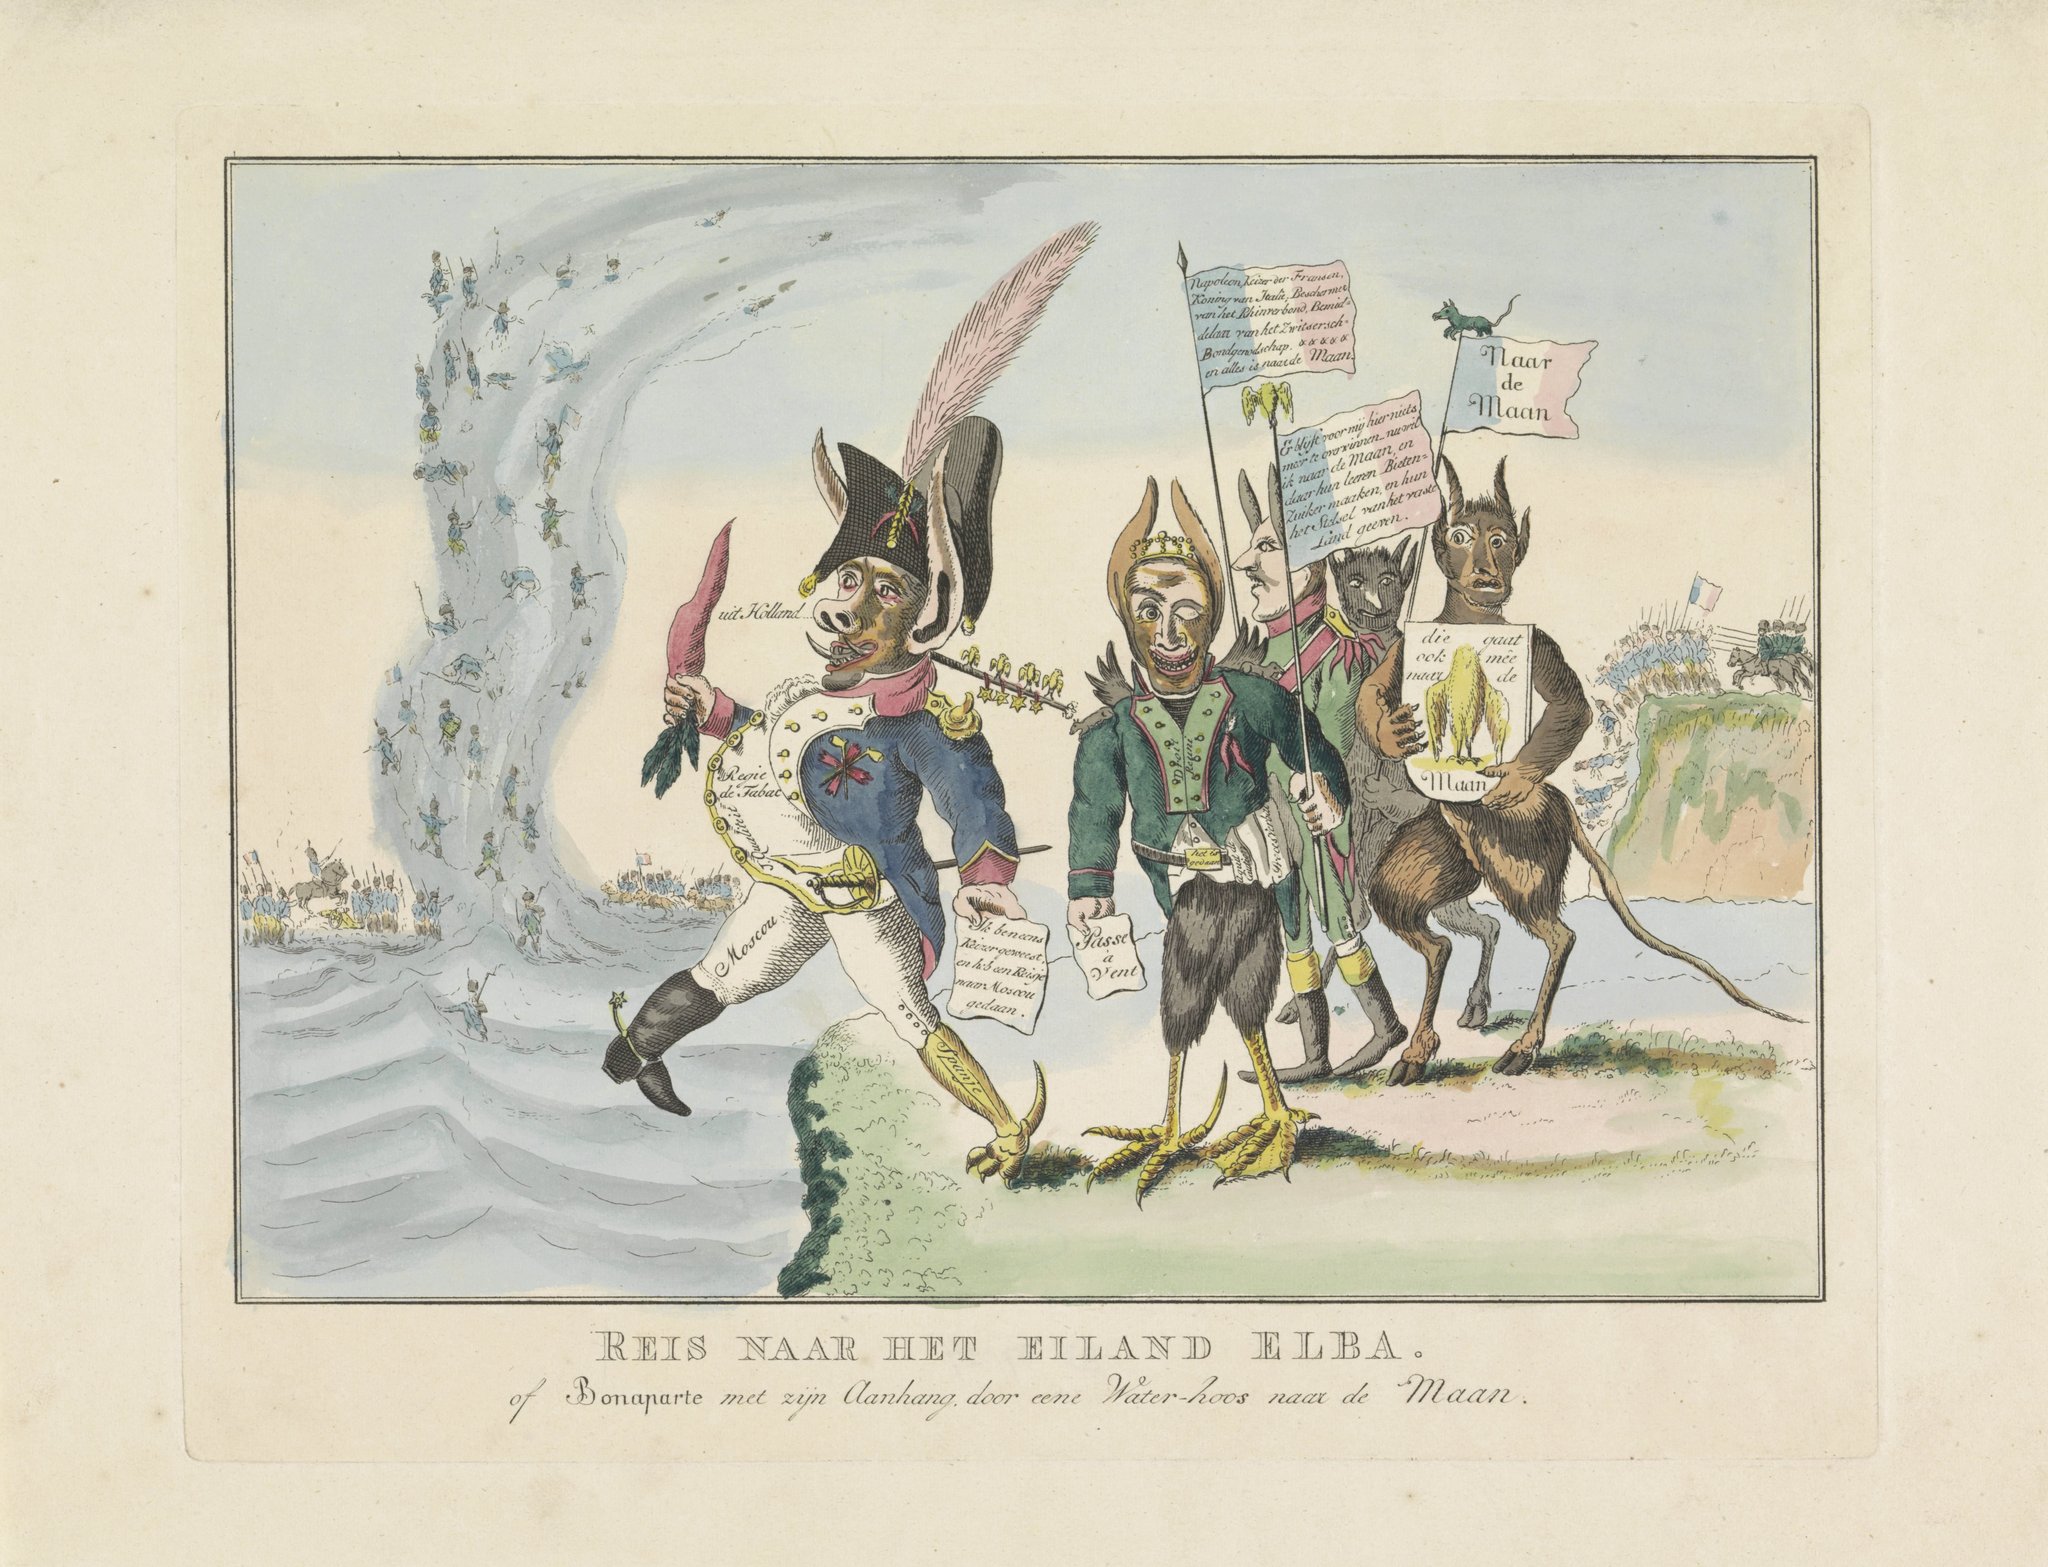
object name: print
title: Verbanning van Napoleon naar Elba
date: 1814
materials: paper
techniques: engraving, etching, hand coloring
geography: netherlands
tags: napoleon i (emperor of the french), whirlwind, cyclone, hurricane, typhoon, tornado at sea, devil(s) and demons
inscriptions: collector's mark: Lugt 2228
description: Spotprent op Napoleons verbanning naar Elba en aankomst daar op 4 mei 1814. Napoleon als een karikaturaal misvormd wezen die van het land het water instapt. Achter hem twee Franse generaals met ezelsoren, de voorste met vogelpoten. Achteraan de duivel met een Franse vlag met opschrift 'Naar de Maan'. Op de achtergrond rechts kozakken die Franse soldaten het water indrijven, links Franse soldaten die in een waterhoos de lucht in - naar de maan - worden gezogen.